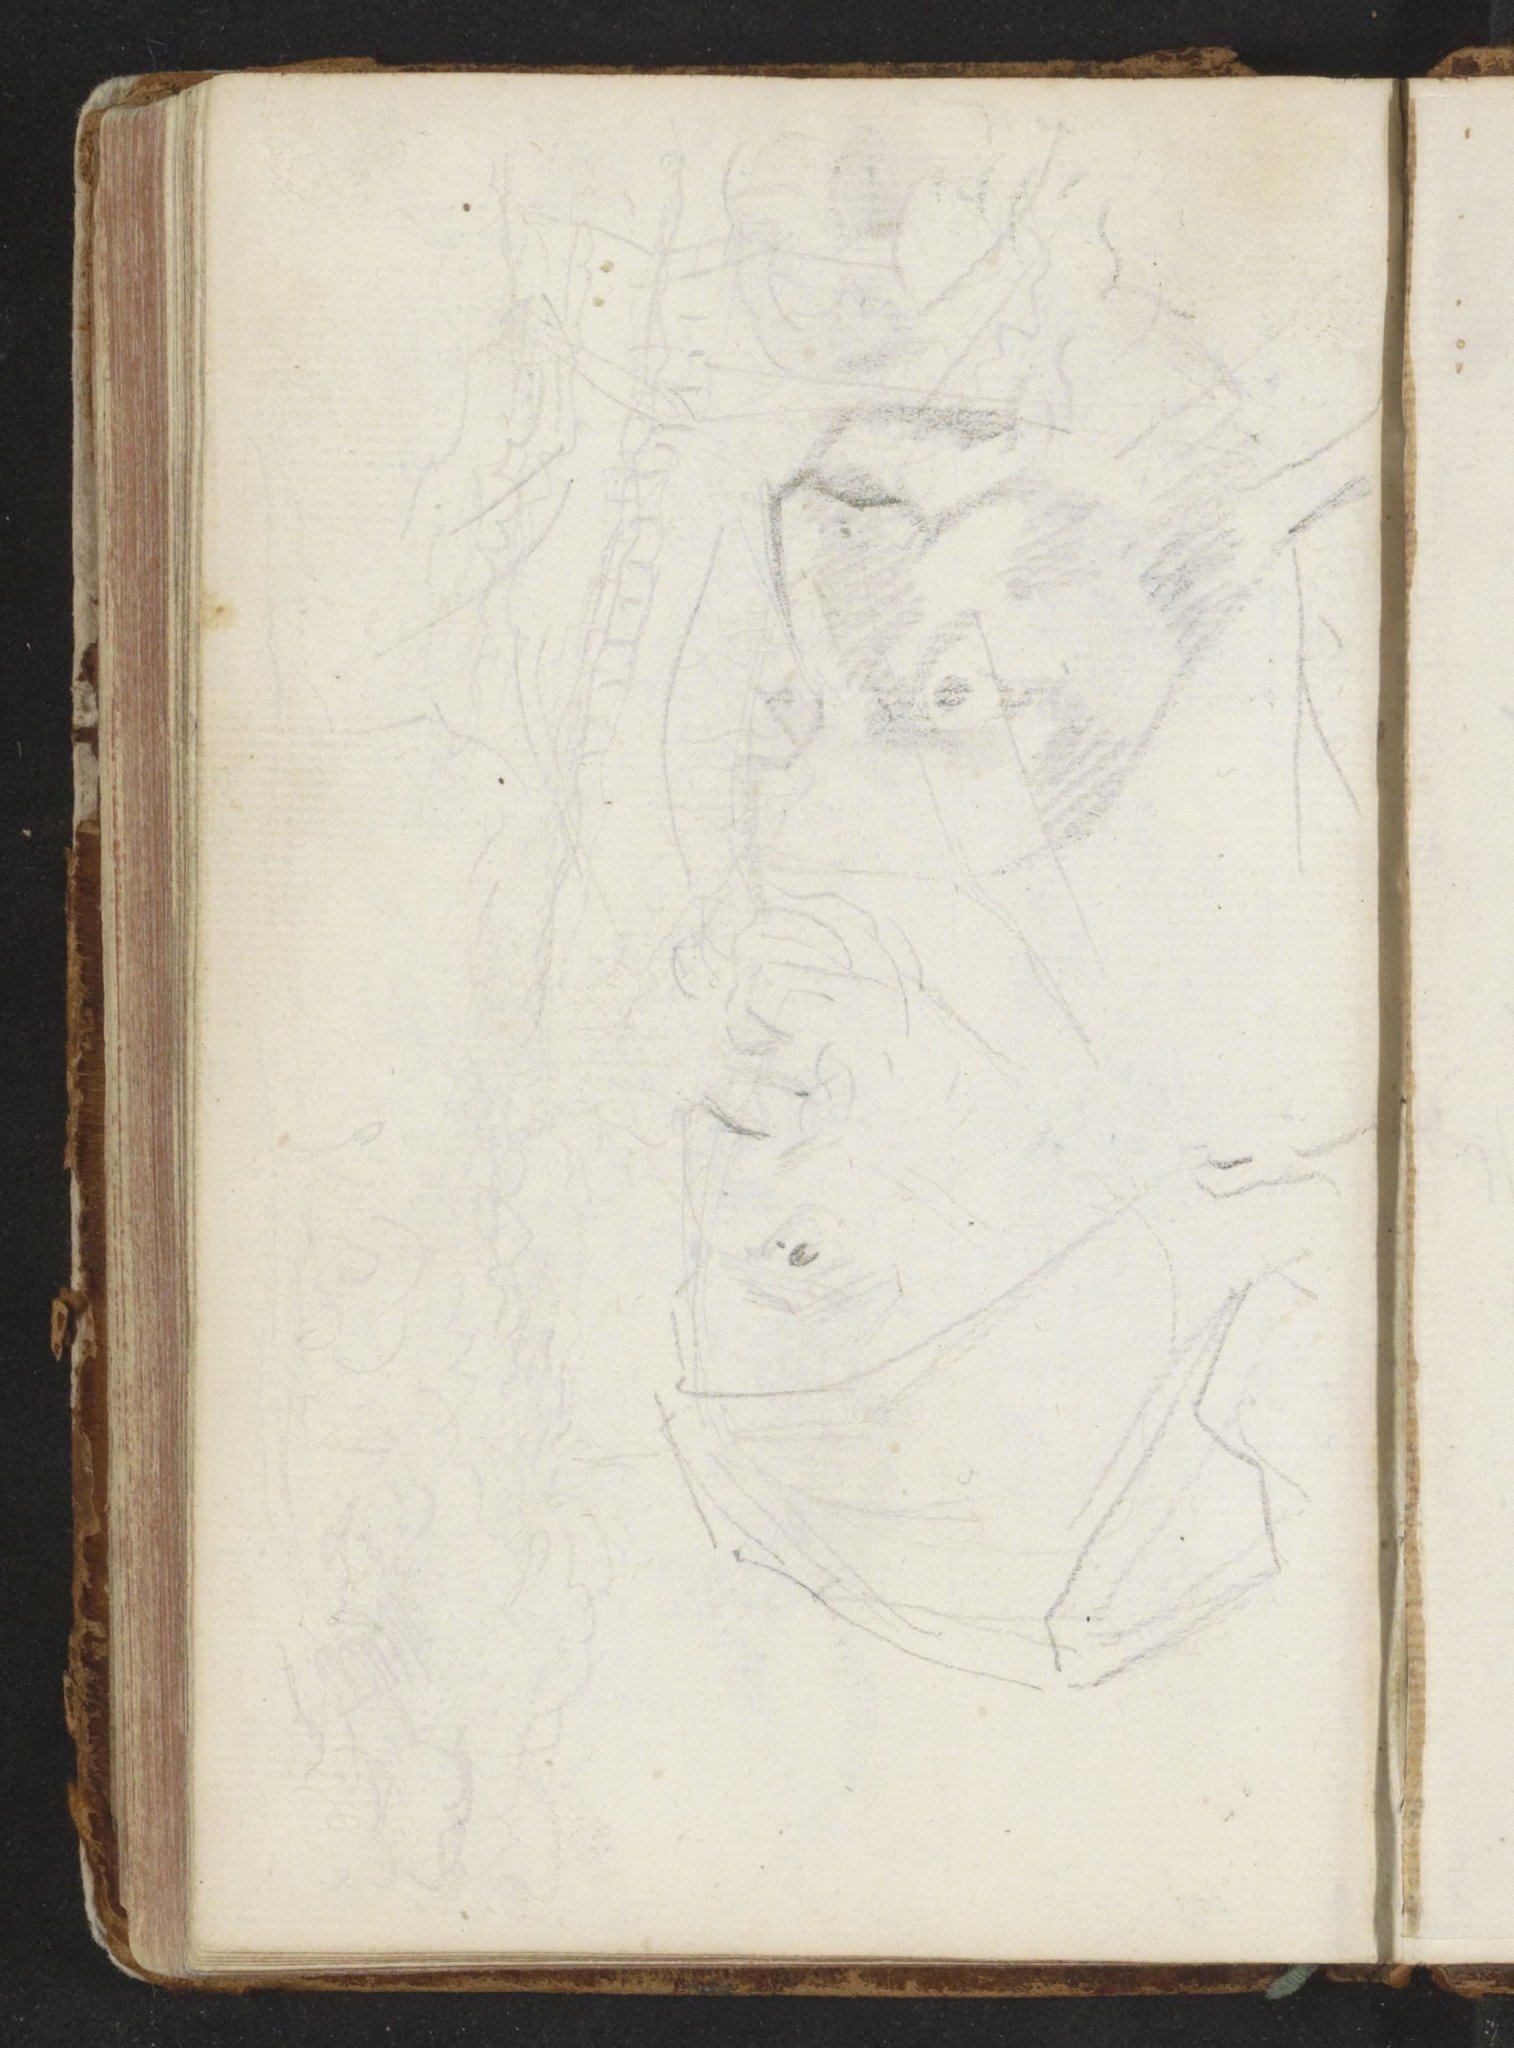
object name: sketchbook leaf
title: Koppen van een man met een muts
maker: jean honoré fragonard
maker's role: draughtsman, painter, print maker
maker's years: 1732-1806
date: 1765-1775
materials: paper, pencil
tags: head (human)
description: Tevens een landschap. Blad 77 verso uit een schetsboek met 83 bladen.